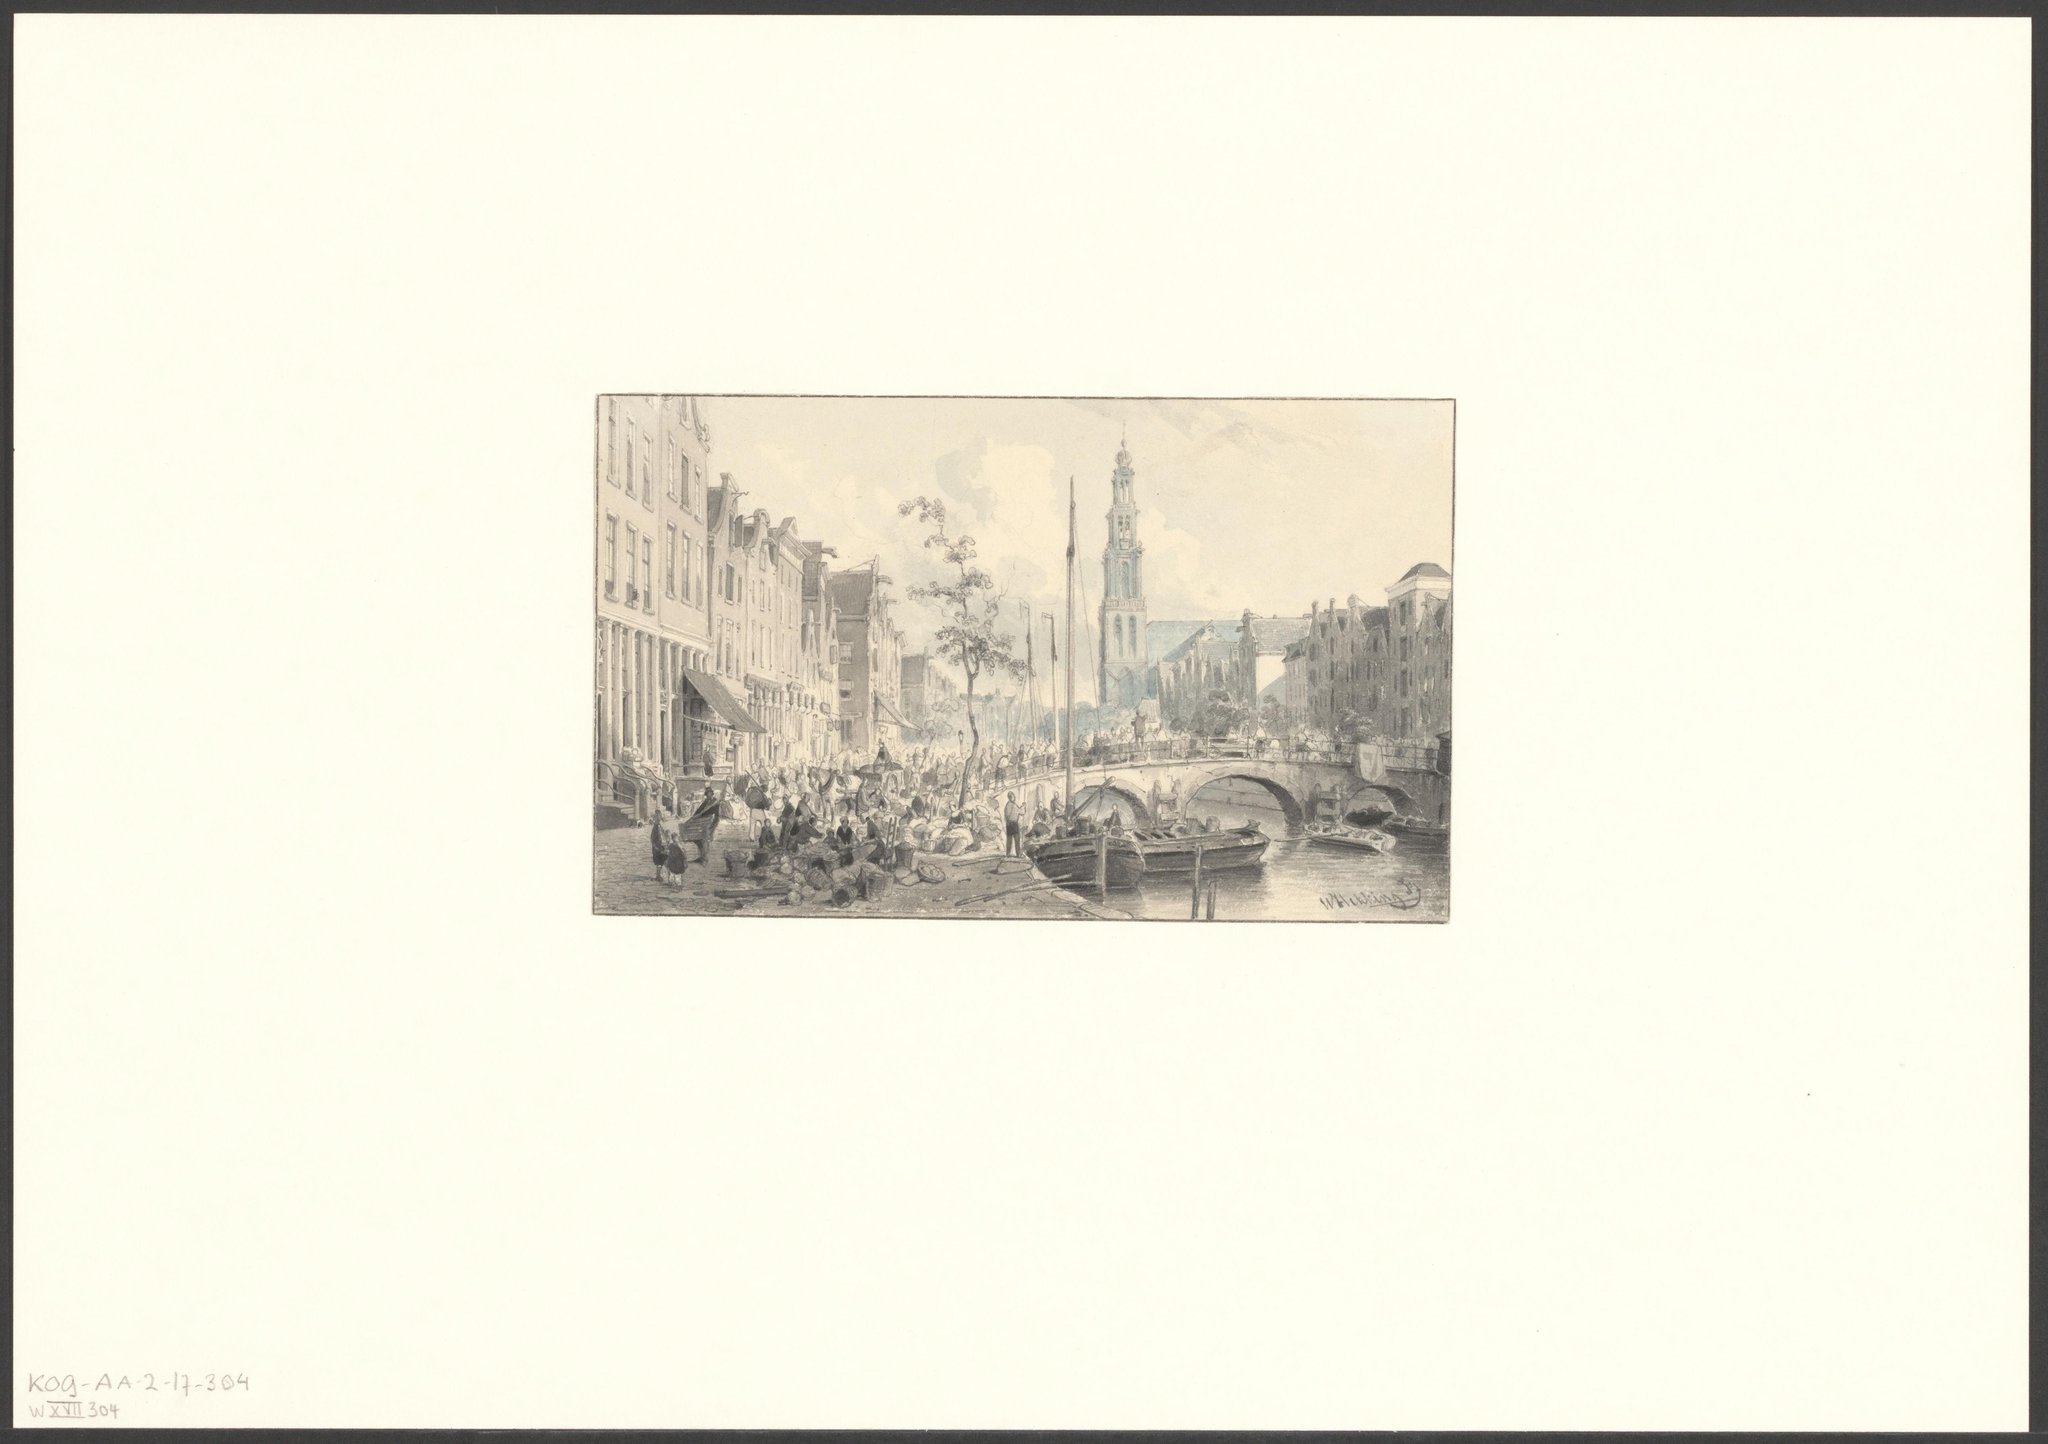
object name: drawing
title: Gezicht op de Prinsengracht en de Westertoren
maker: willem hekking jr.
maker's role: print maker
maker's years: 1825-1904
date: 1835-1904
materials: ink, paper, pencil, watercolor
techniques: brush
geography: amsterdam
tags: tower, clock tower ~ monumental adornment, city-view in general; 'veduta', canal, parts of church exterior and annexes: spire, bridge in city across river, canal, etc.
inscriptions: signature: ‘WHekkingjr.f’, collector's mark: Lugt 800a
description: Tekening binnen de Atlas Van Eck ingedeeld op wijknummer 17.